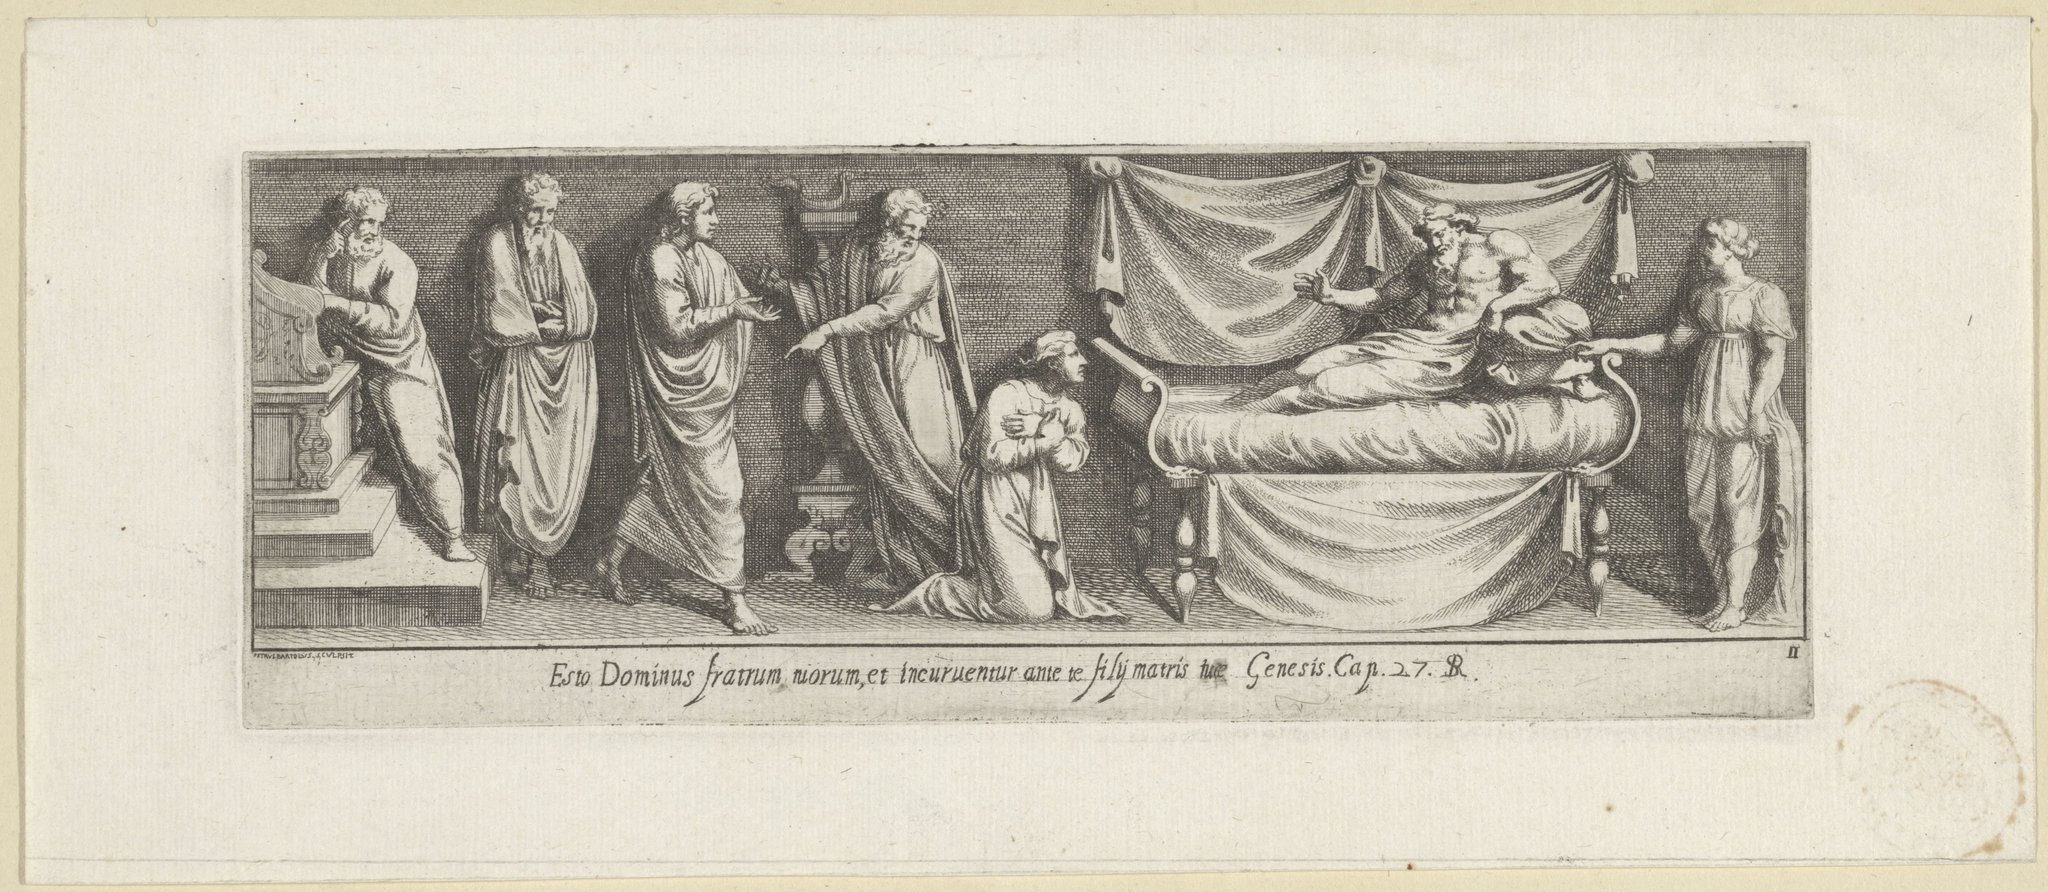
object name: print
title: Jakob wordt gezegend door Isaak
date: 1645-1700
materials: paper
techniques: engraving, etching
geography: vatican city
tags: isaac's blessing (of jacob and esau) (genesis 27)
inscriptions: collector's mark: Lugt 240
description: Isaak ligt in bed en zegent Jakob, die aan het voeteneinde staat. Rebekka staat rechts. Links staan vier mannen in toga's. Titel en verwijzing naar Bijbeltekst in ondermarge.